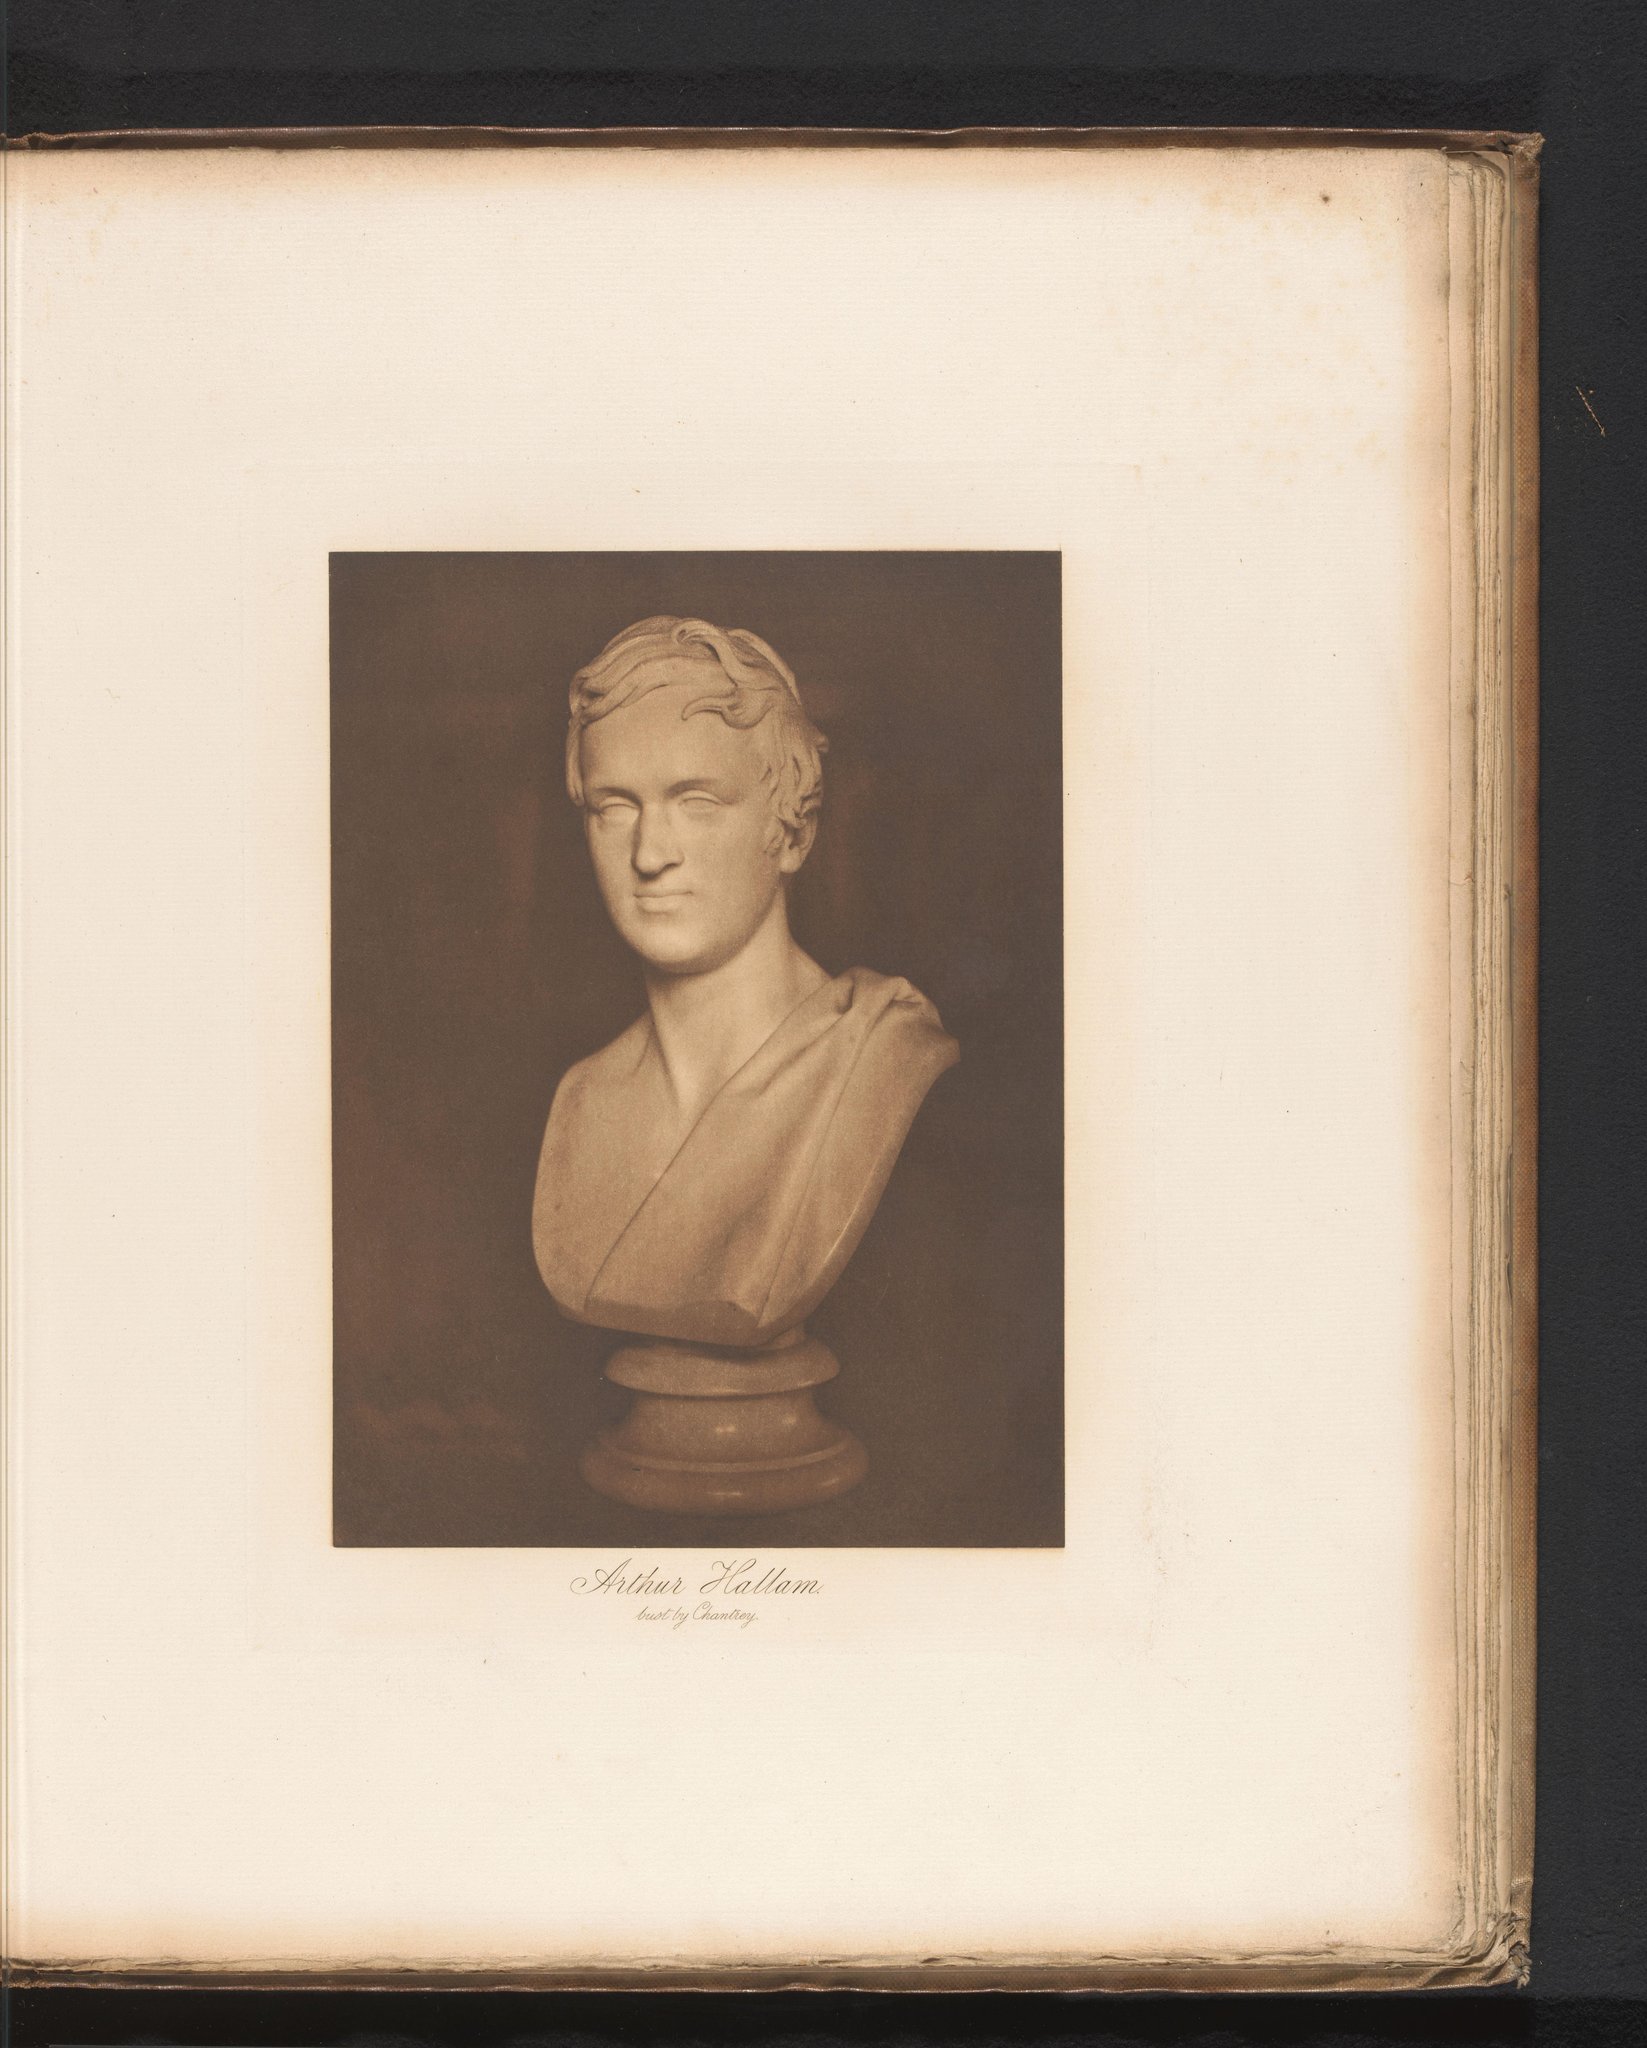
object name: photomechanical print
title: Buste van Arthur Hallam door Francis Leggatt Chantrey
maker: henry herschel hay cameron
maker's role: fotograaf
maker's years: 1852-1911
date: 1888-1893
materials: paper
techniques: photoaquatint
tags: historical persons, piece of sculpture, reproduction of a piece of sculpture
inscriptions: inscription: ‘Arthur Hallam/ bust by Chantrey’